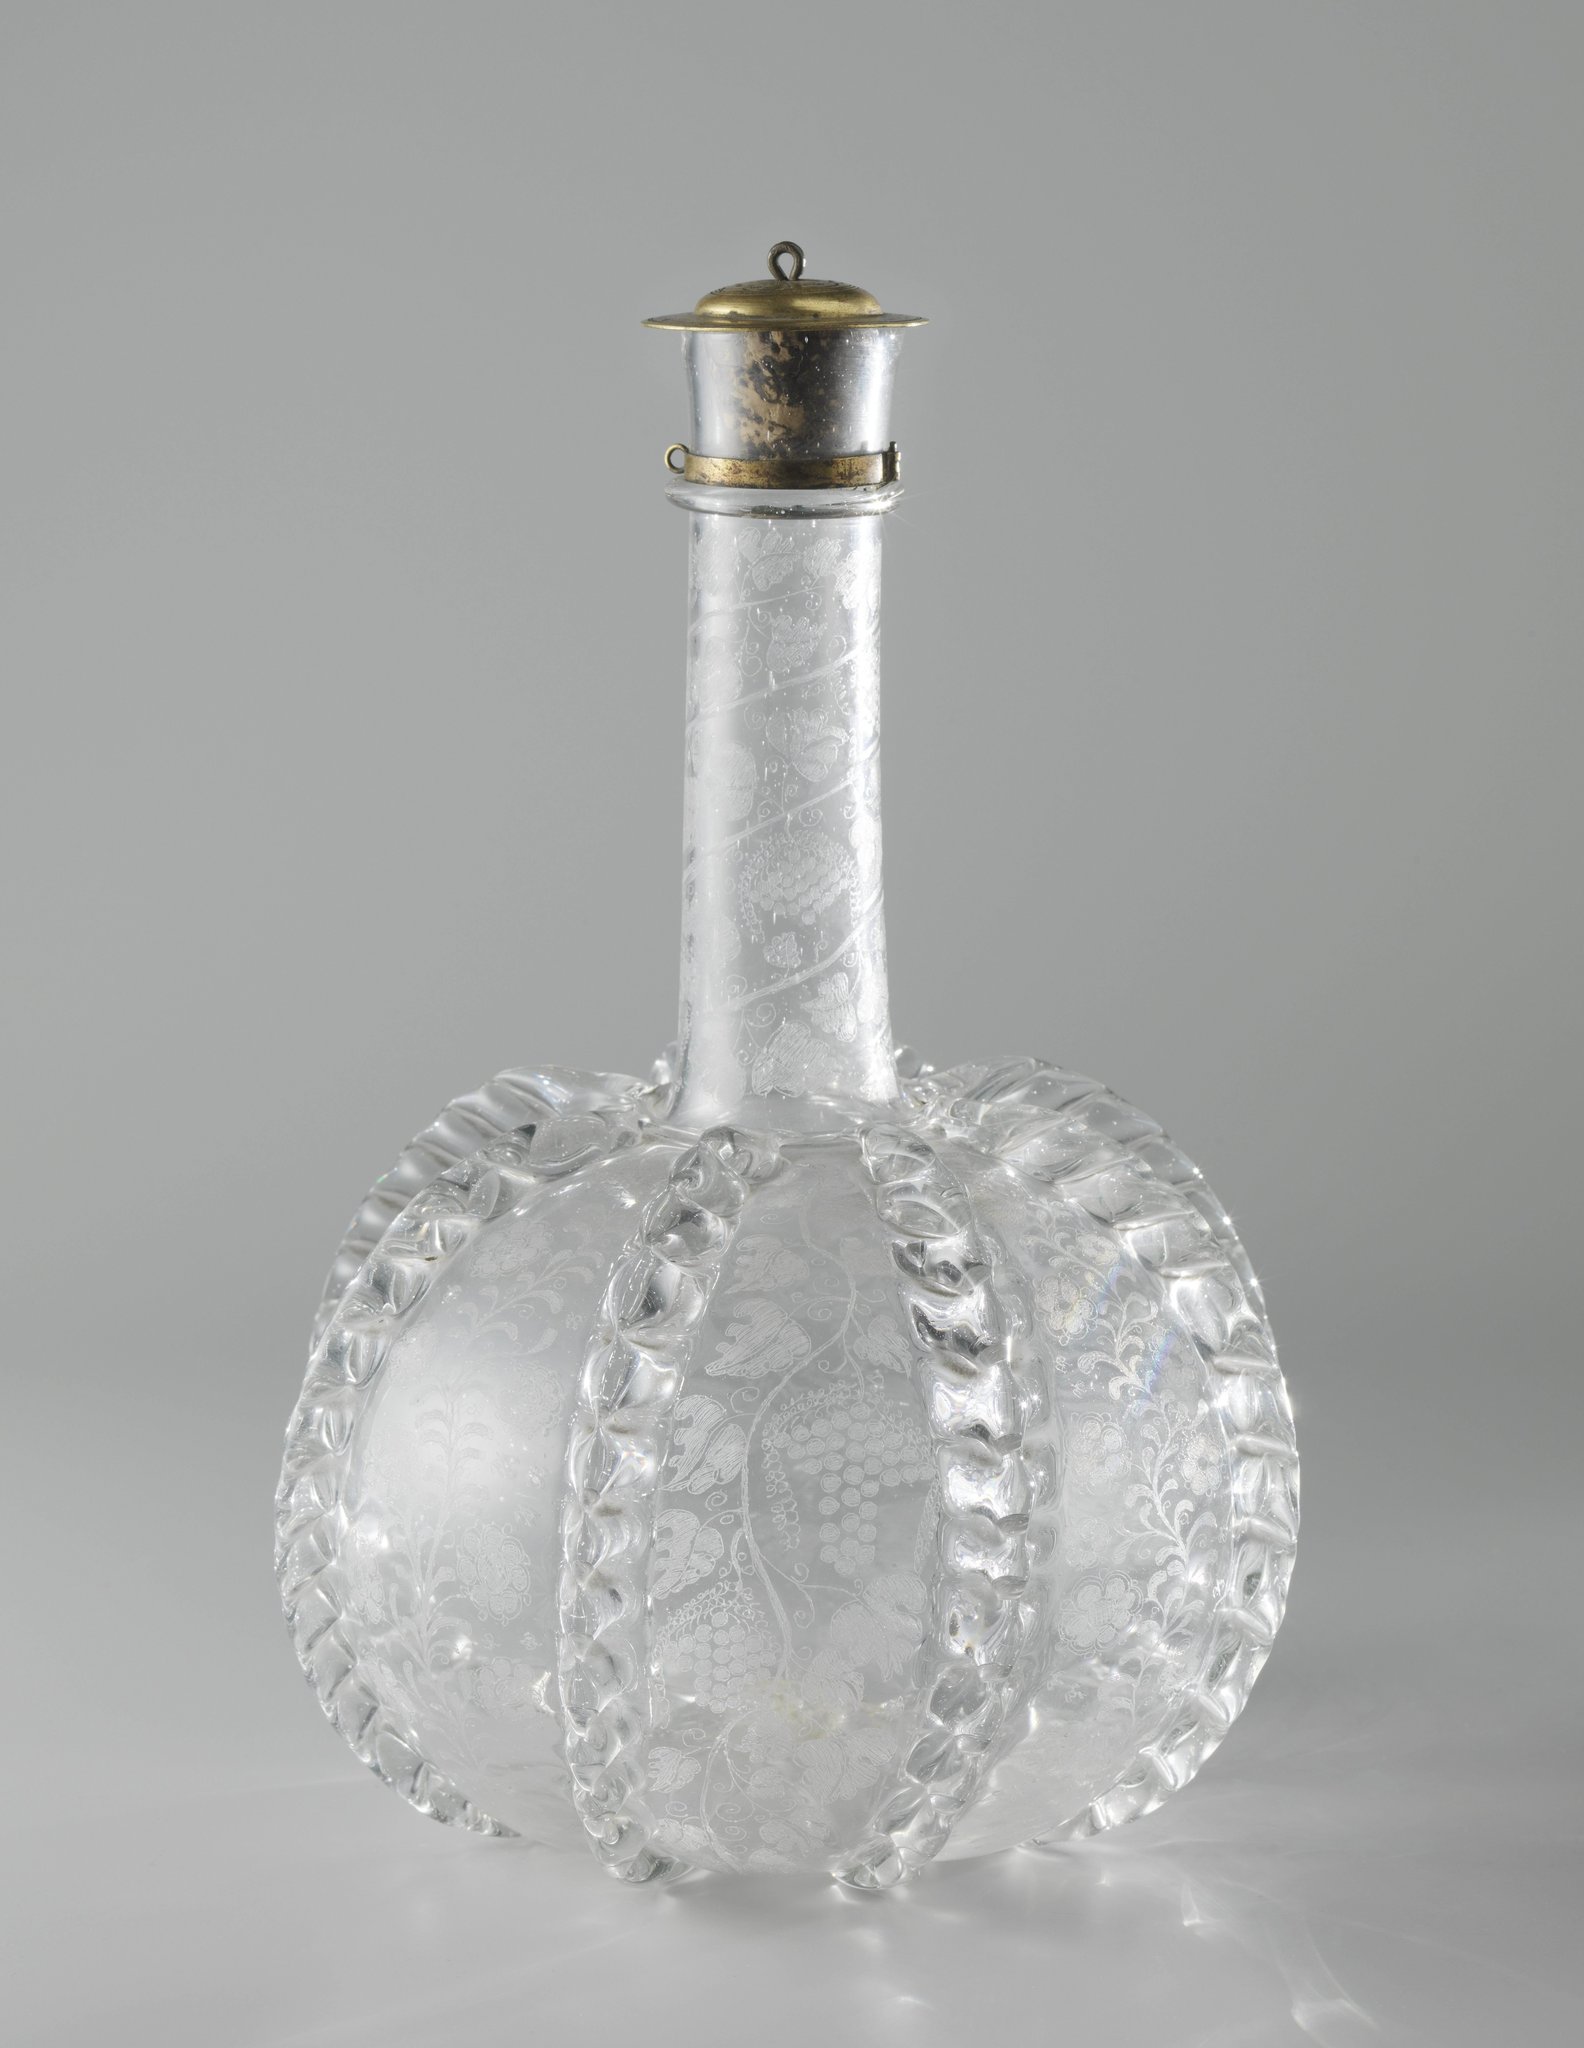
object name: bottle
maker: Anonymous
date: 1675-1700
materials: glass, metal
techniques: diamond point engraving, façon de venise, gilding, glassblowing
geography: low countries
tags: vine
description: This bottle was part of the collection of glass that King William III presented to the Koninklijk Oudheidkundig Genootschap (Royal Antiquarian Society) in 1859.